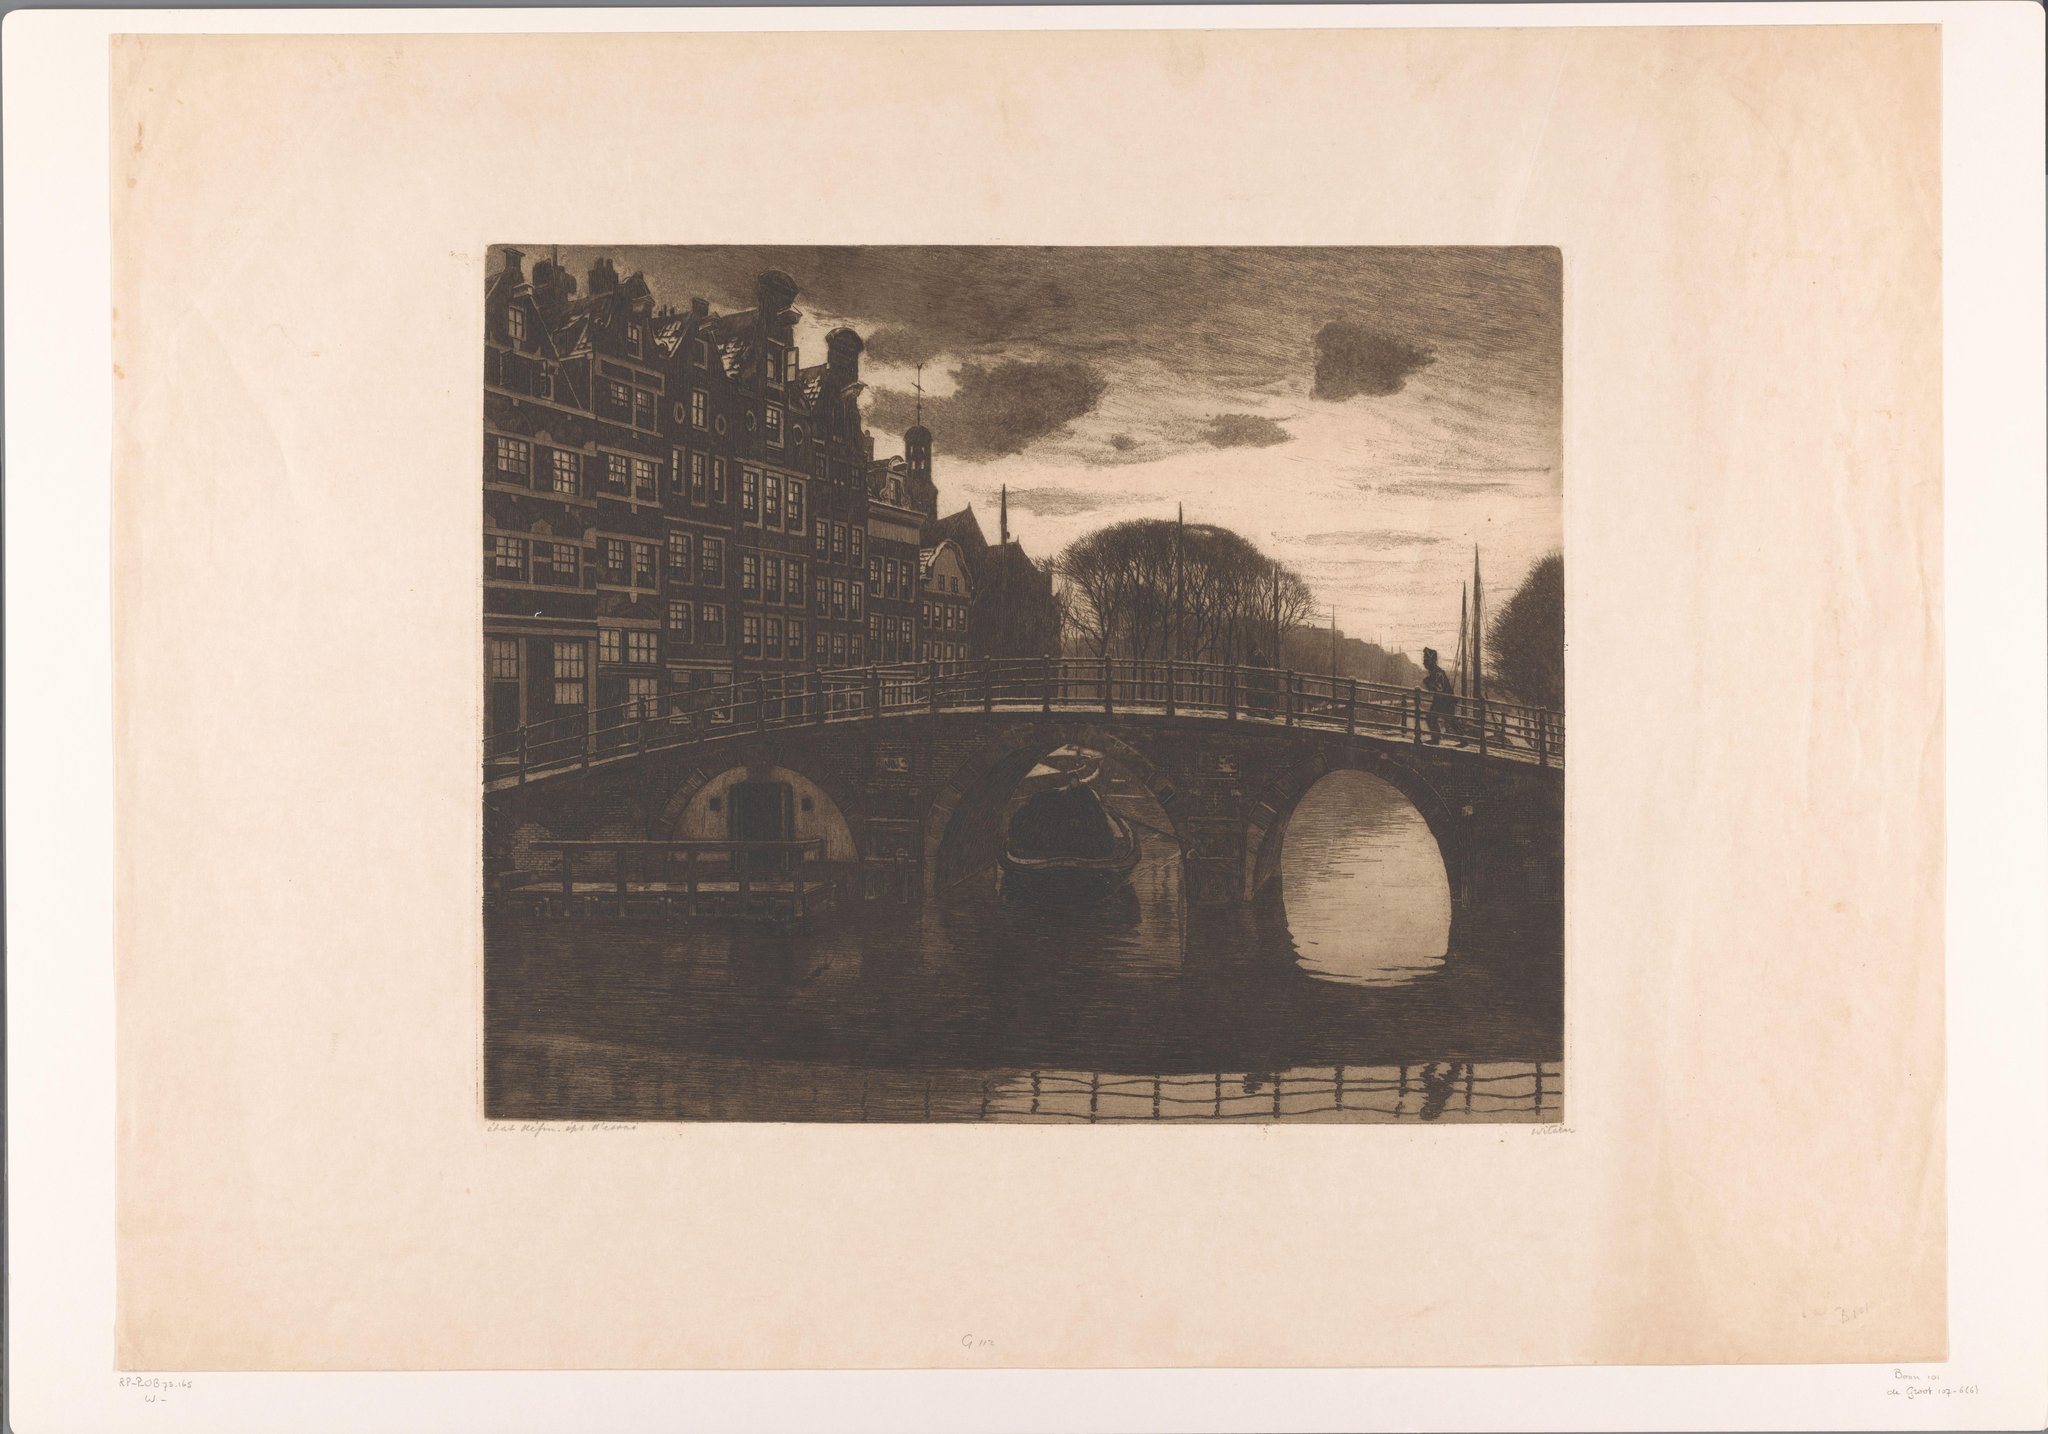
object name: print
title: Brouwersgracht te Amsterdam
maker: willem witsen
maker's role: draughtsman, painter, print maker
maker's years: 1860-1923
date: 1875-1923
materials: paper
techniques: aquatint, etching, intaglio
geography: netherlands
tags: canals, waters (in city)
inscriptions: collector's mark: Lugt 2228